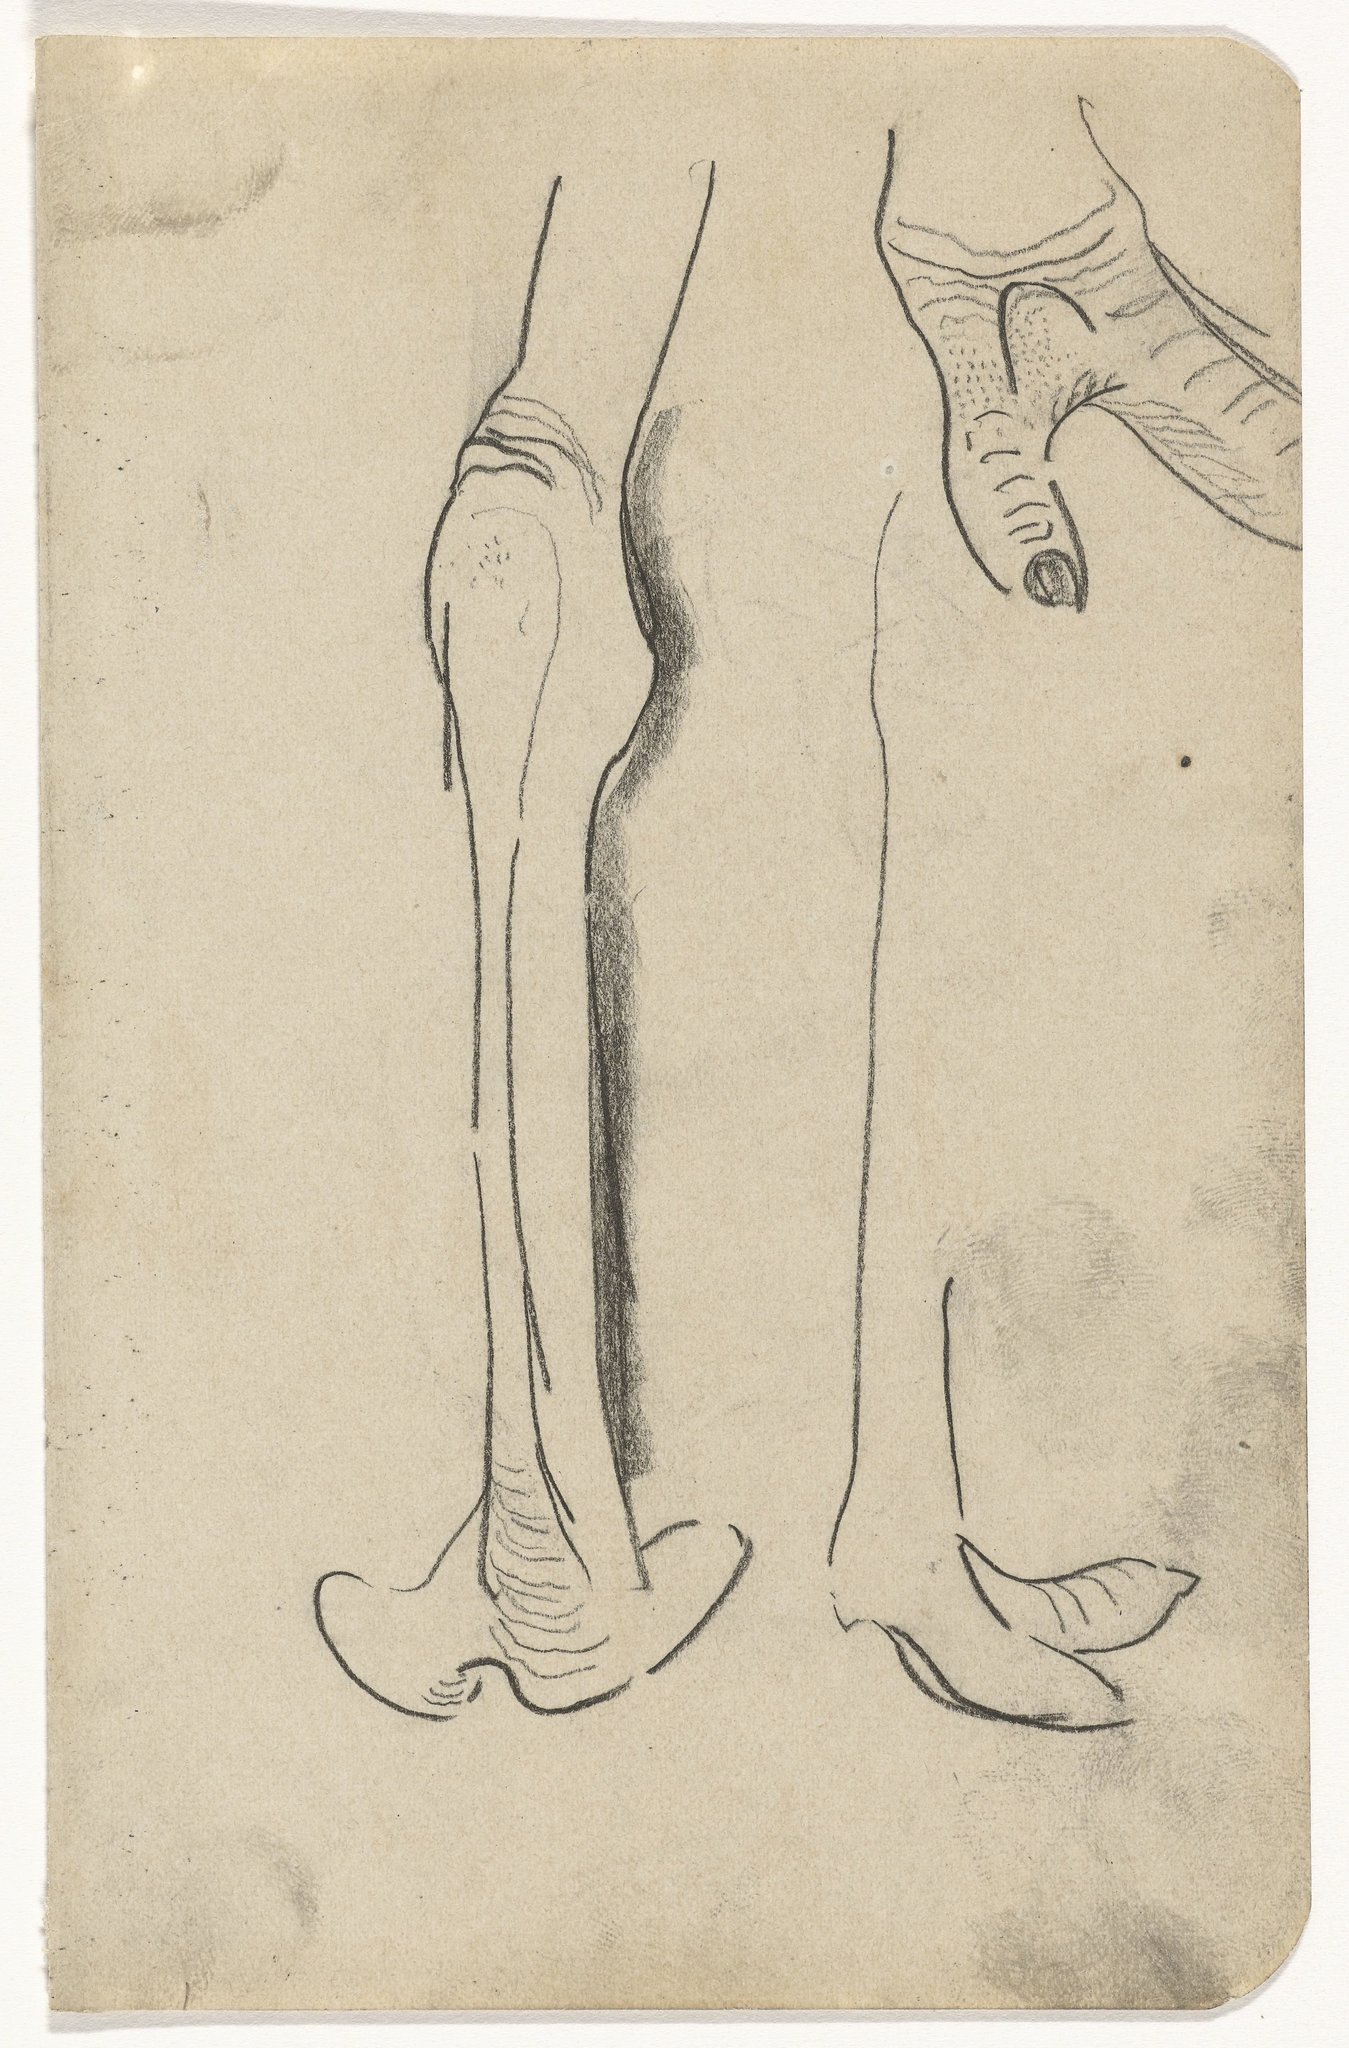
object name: drawing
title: Poten van een vogel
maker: gerrit willem dijsselhof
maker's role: designer, draughtsman, print maker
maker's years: 1866-1924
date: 1876-1924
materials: chalk, paper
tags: walker and runner birds (+ limbs of an animal)